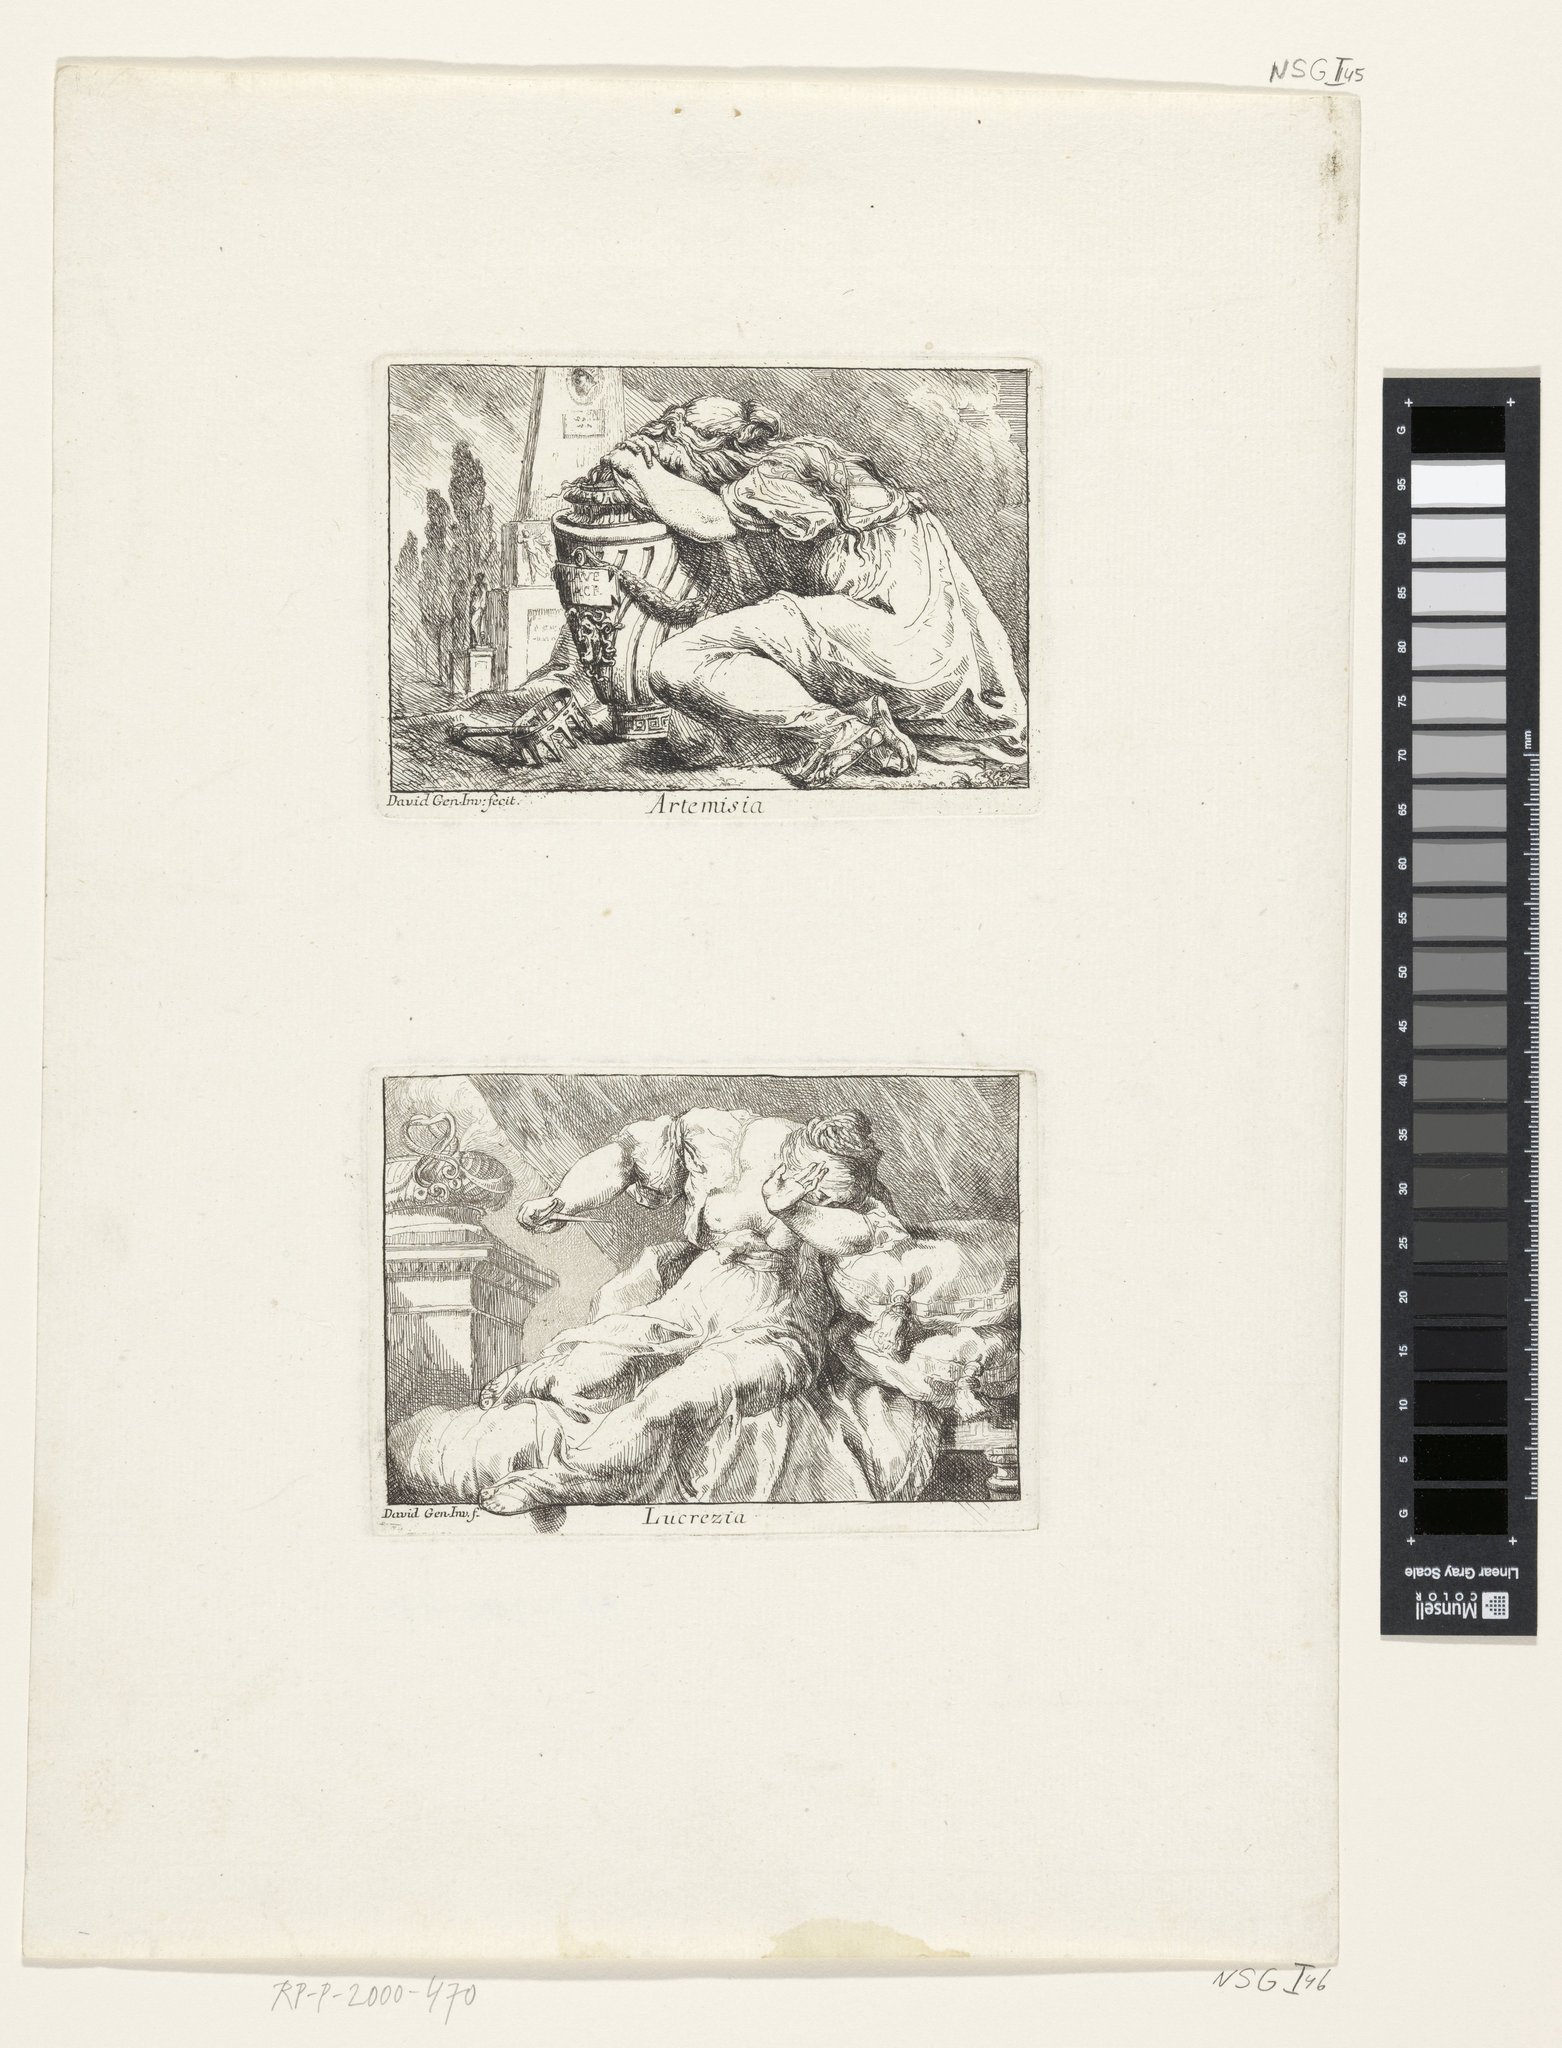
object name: print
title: Artemisia / Lucretia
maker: giovanni david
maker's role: print maker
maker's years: 1743-1790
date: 1753-1790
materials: paper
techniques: etching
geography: italy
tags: suffering, misfortune of lucretia, suffering, misfortune of artemisia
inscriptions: collector's mark: Lugt 2228, collector's mark: Lugt 2760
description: Blad met twee voorstellingen. Boven: Artemisia treurend bij een grote urn. Naast haar liggen een scepter en een kroon. Onder: Lucretia die op het punt staat zichzelf te doorsteken met haar dolk.